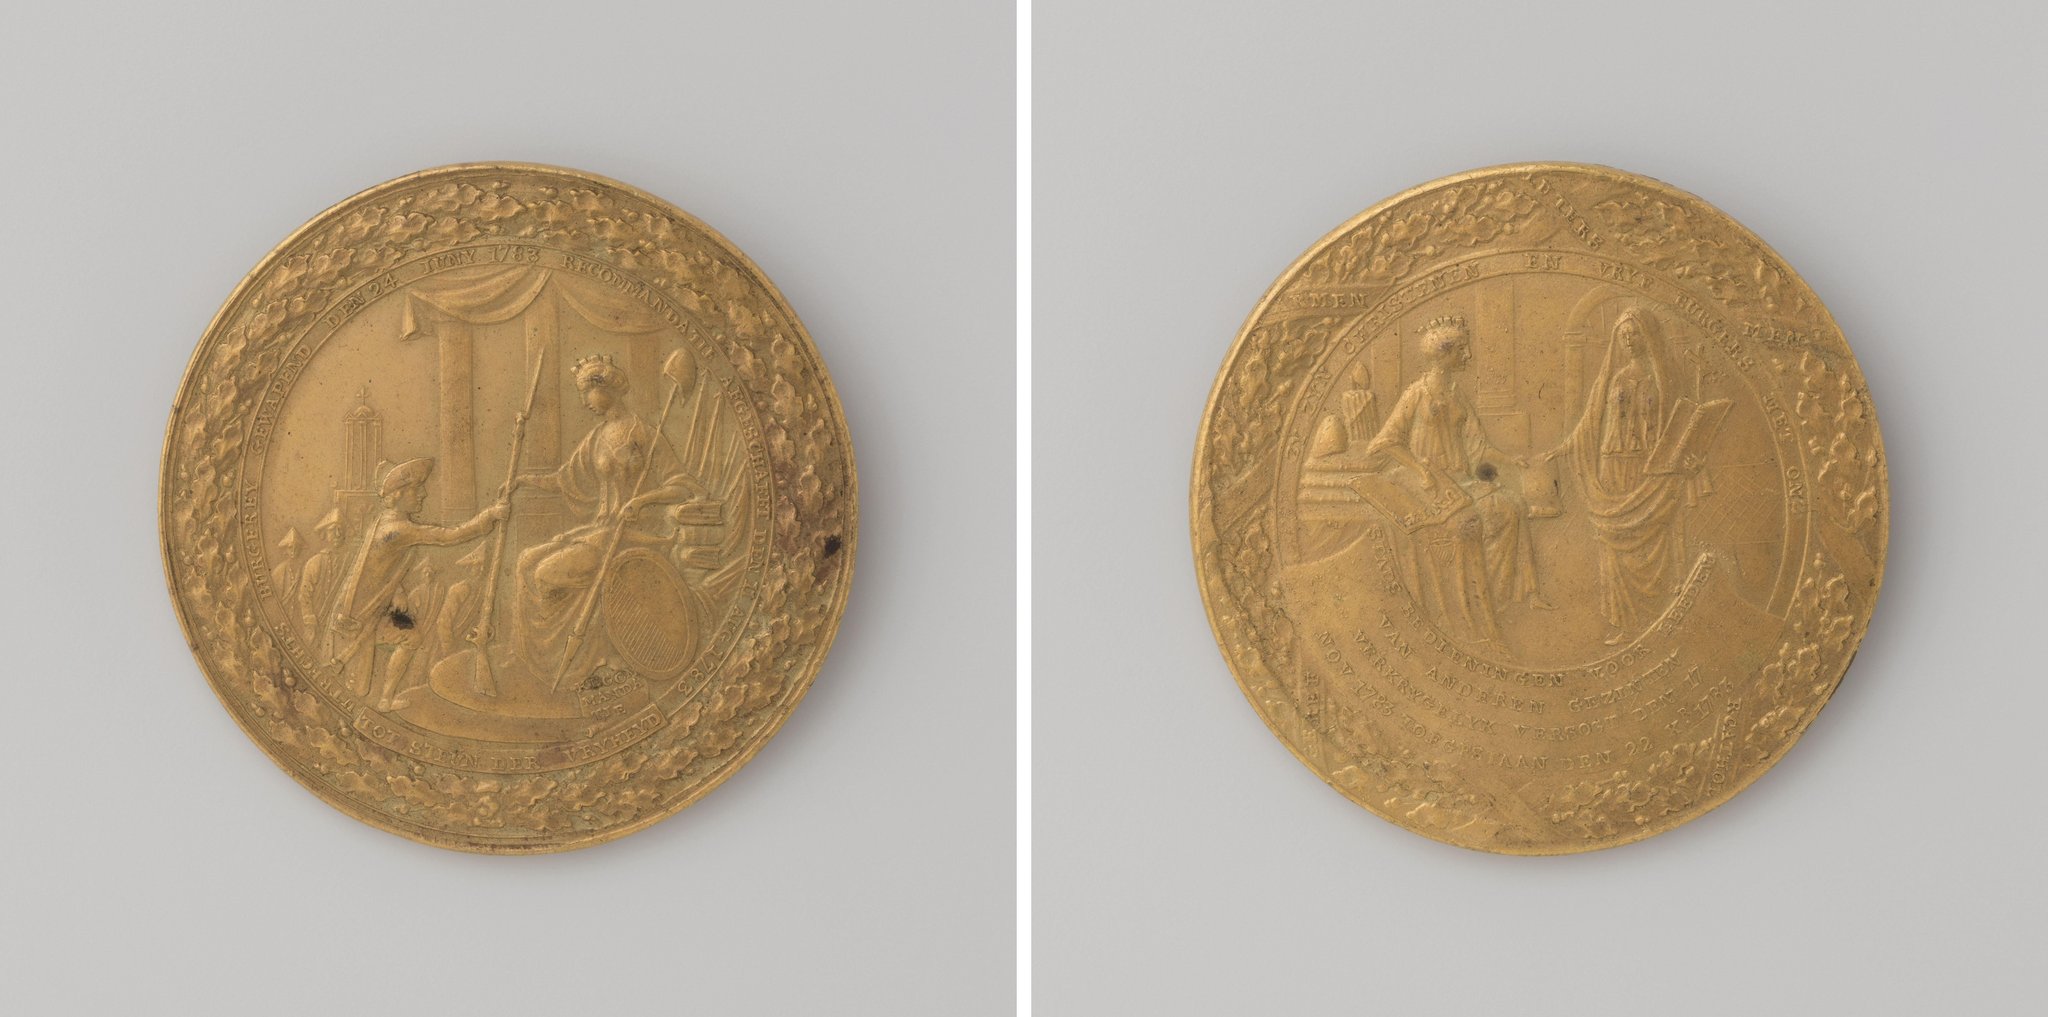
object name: history medal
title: Oprichting van burgercorpsen, de afschaffing van de stadhouderlijke recomandatie en het Openstellen van de lagere ambten voor leden van alle godsdienstige gezindten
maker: Anonymous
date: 1783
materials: gold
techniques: gilding, striking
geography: utrecht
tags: utrecht